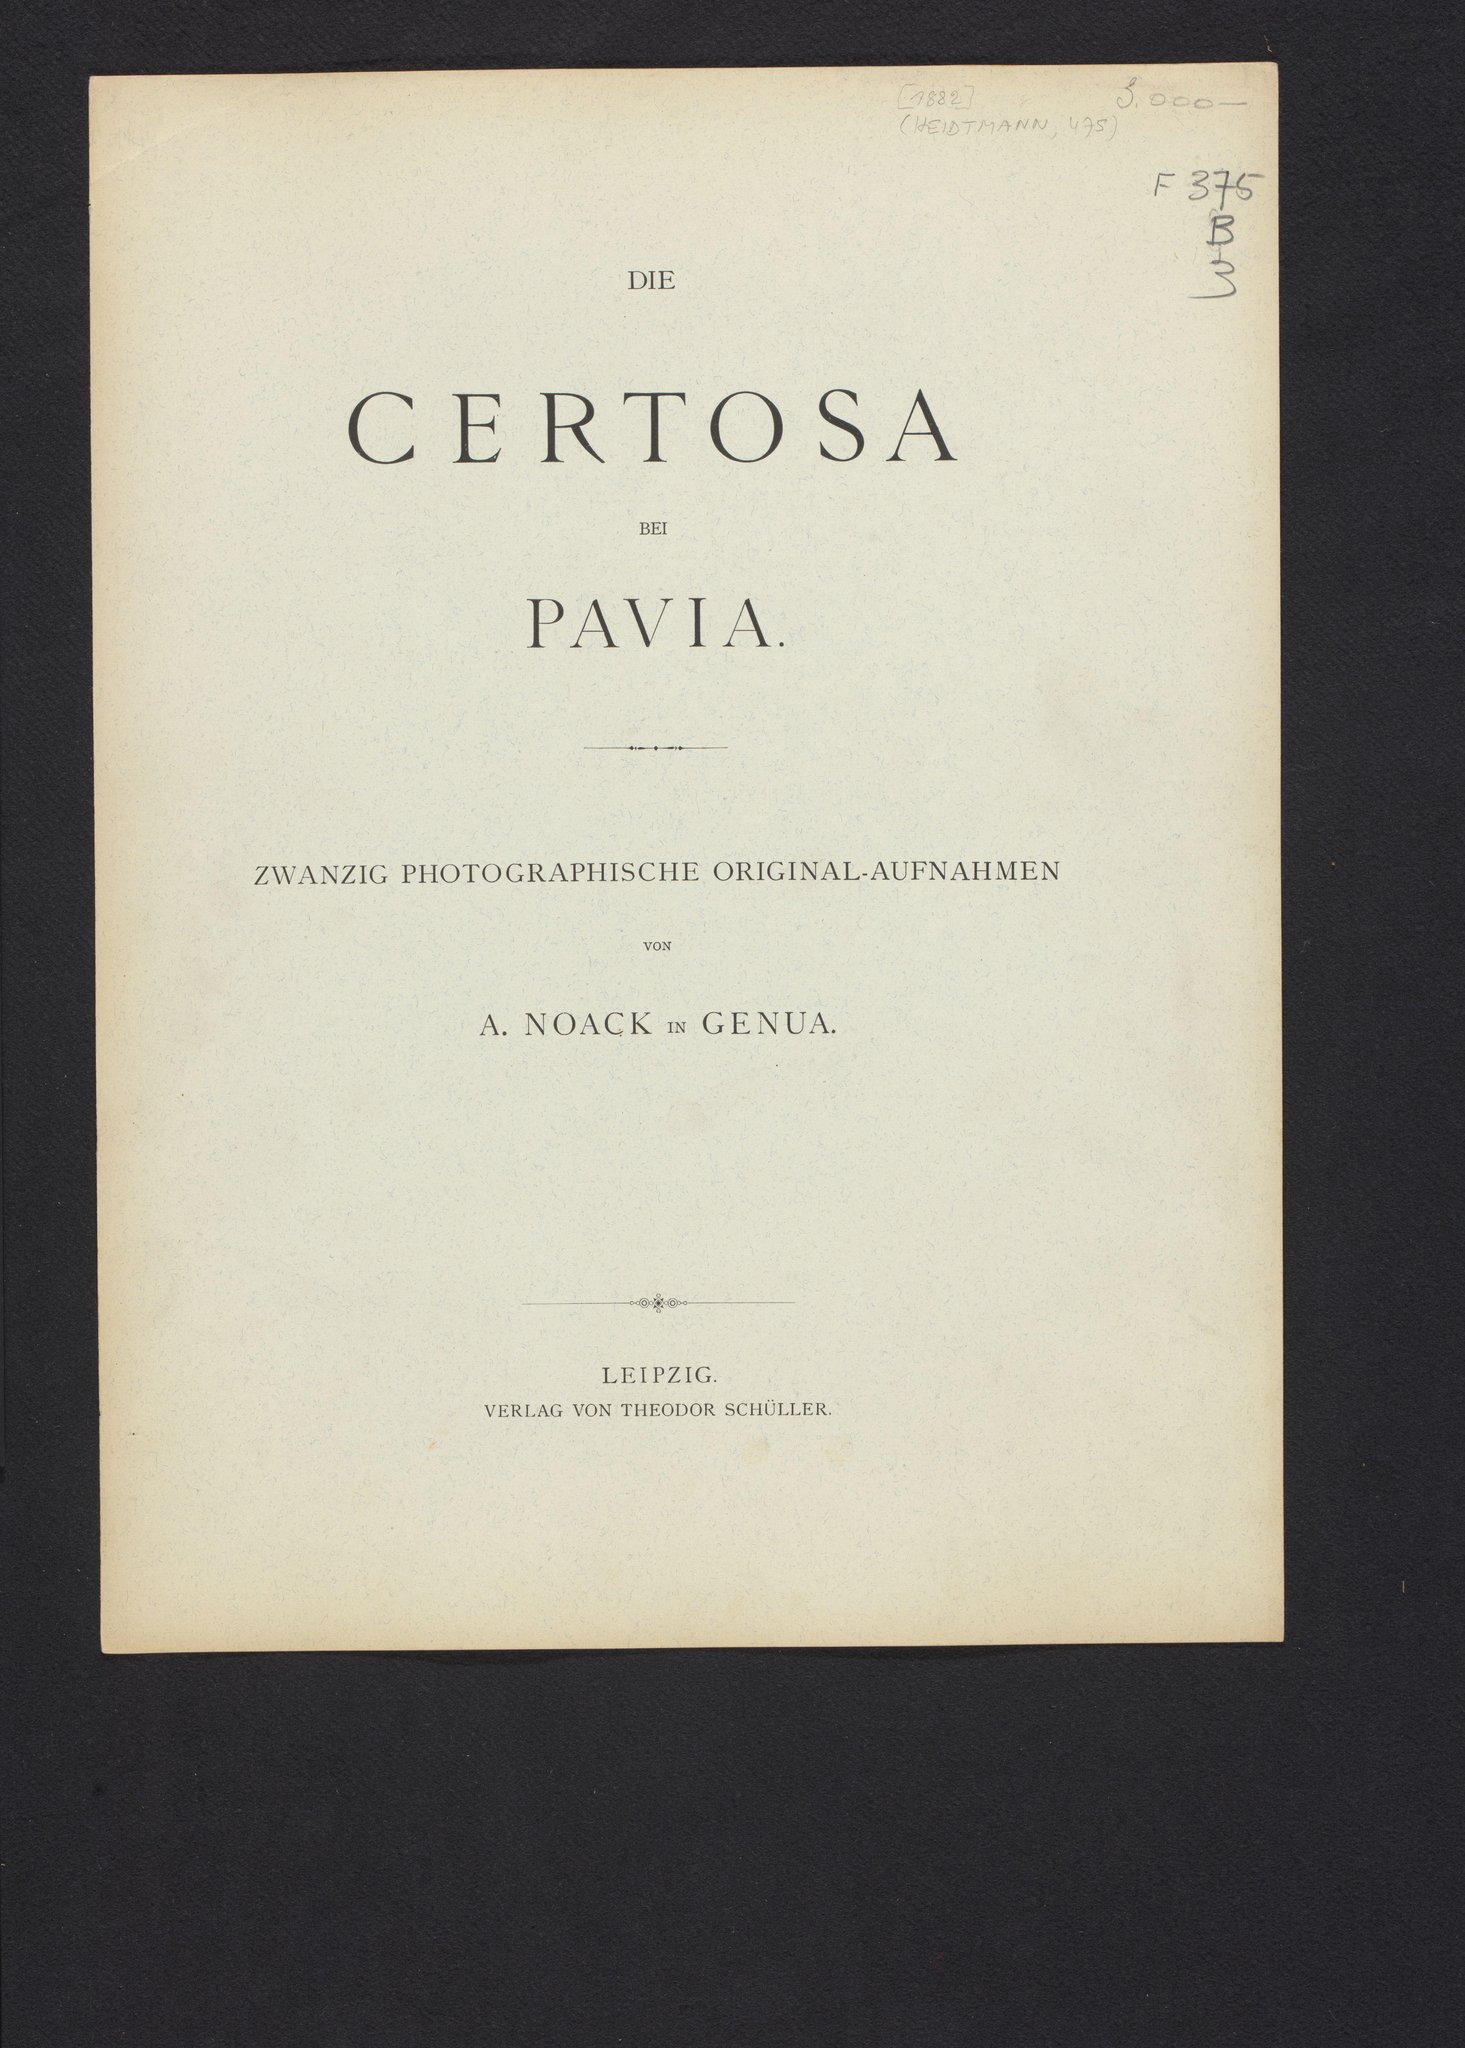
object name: wrapper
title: Die Certosa bei Pavia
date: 1882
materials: cardboard, leather, linen, paper, photographic support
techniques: albumen print, decorated paper, printing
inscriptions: date: ‘SEPT 1990’, annotation: ‘[1882]/ (Heidtmann, 475)/ 3.000-’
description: Omslag met titelpagina en twintig losse platen.